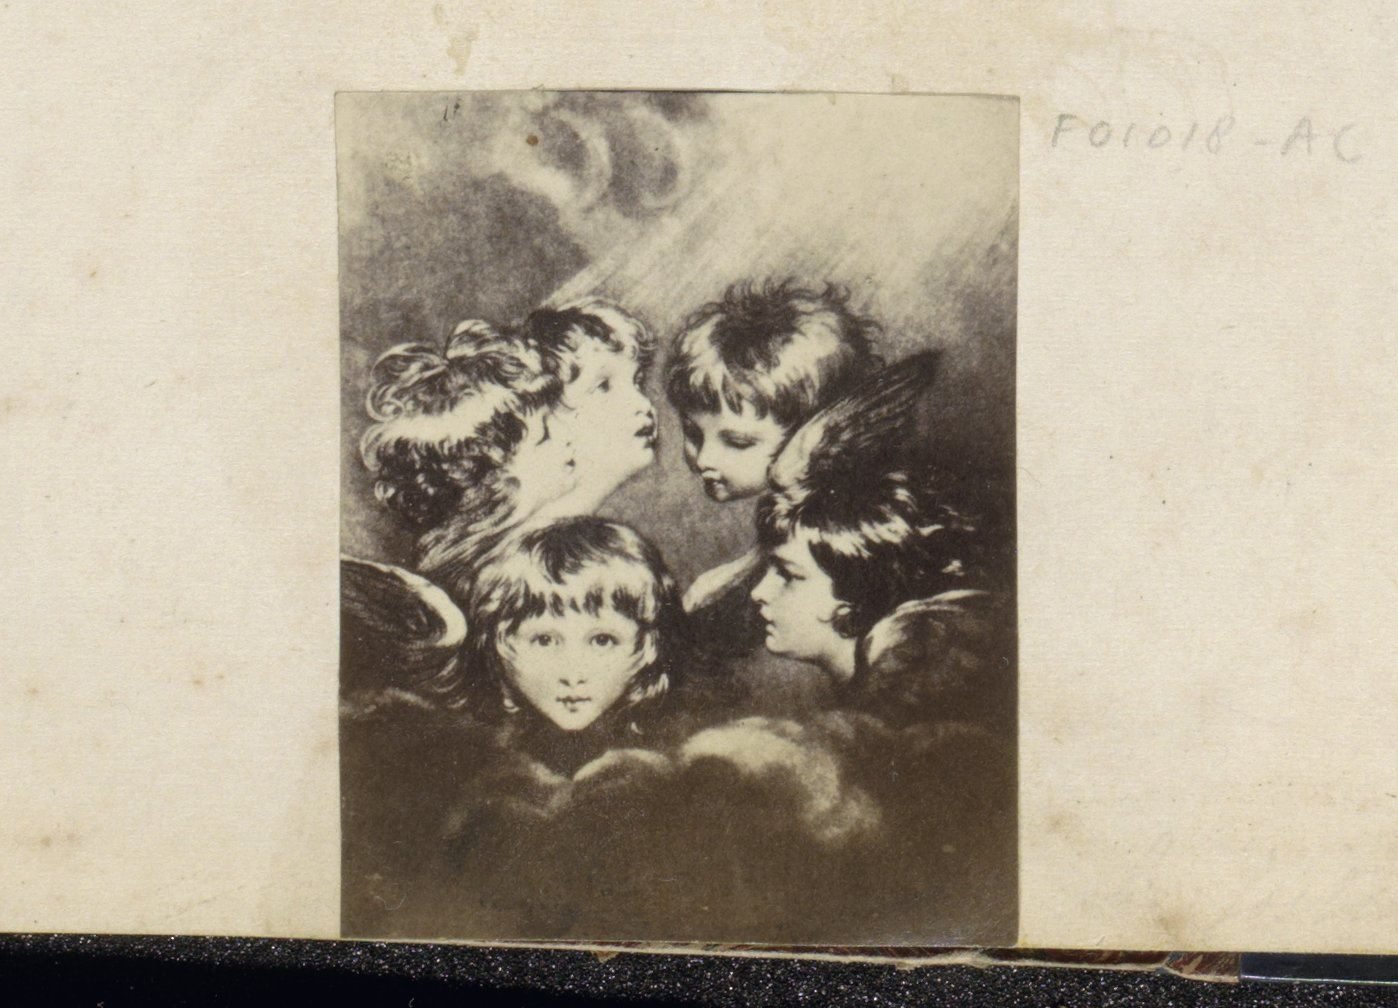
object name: reproduction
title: Fotoreproductie van (vermoedelijk) een schilderij met vijf kinderhoofdjes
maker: Anonymous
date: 1860-1870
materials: paper, photographic support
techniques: albumen print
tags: child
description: Onderdeel van Engels familiealbum met foto's van personen, reizen, cricket en kunstwerken.